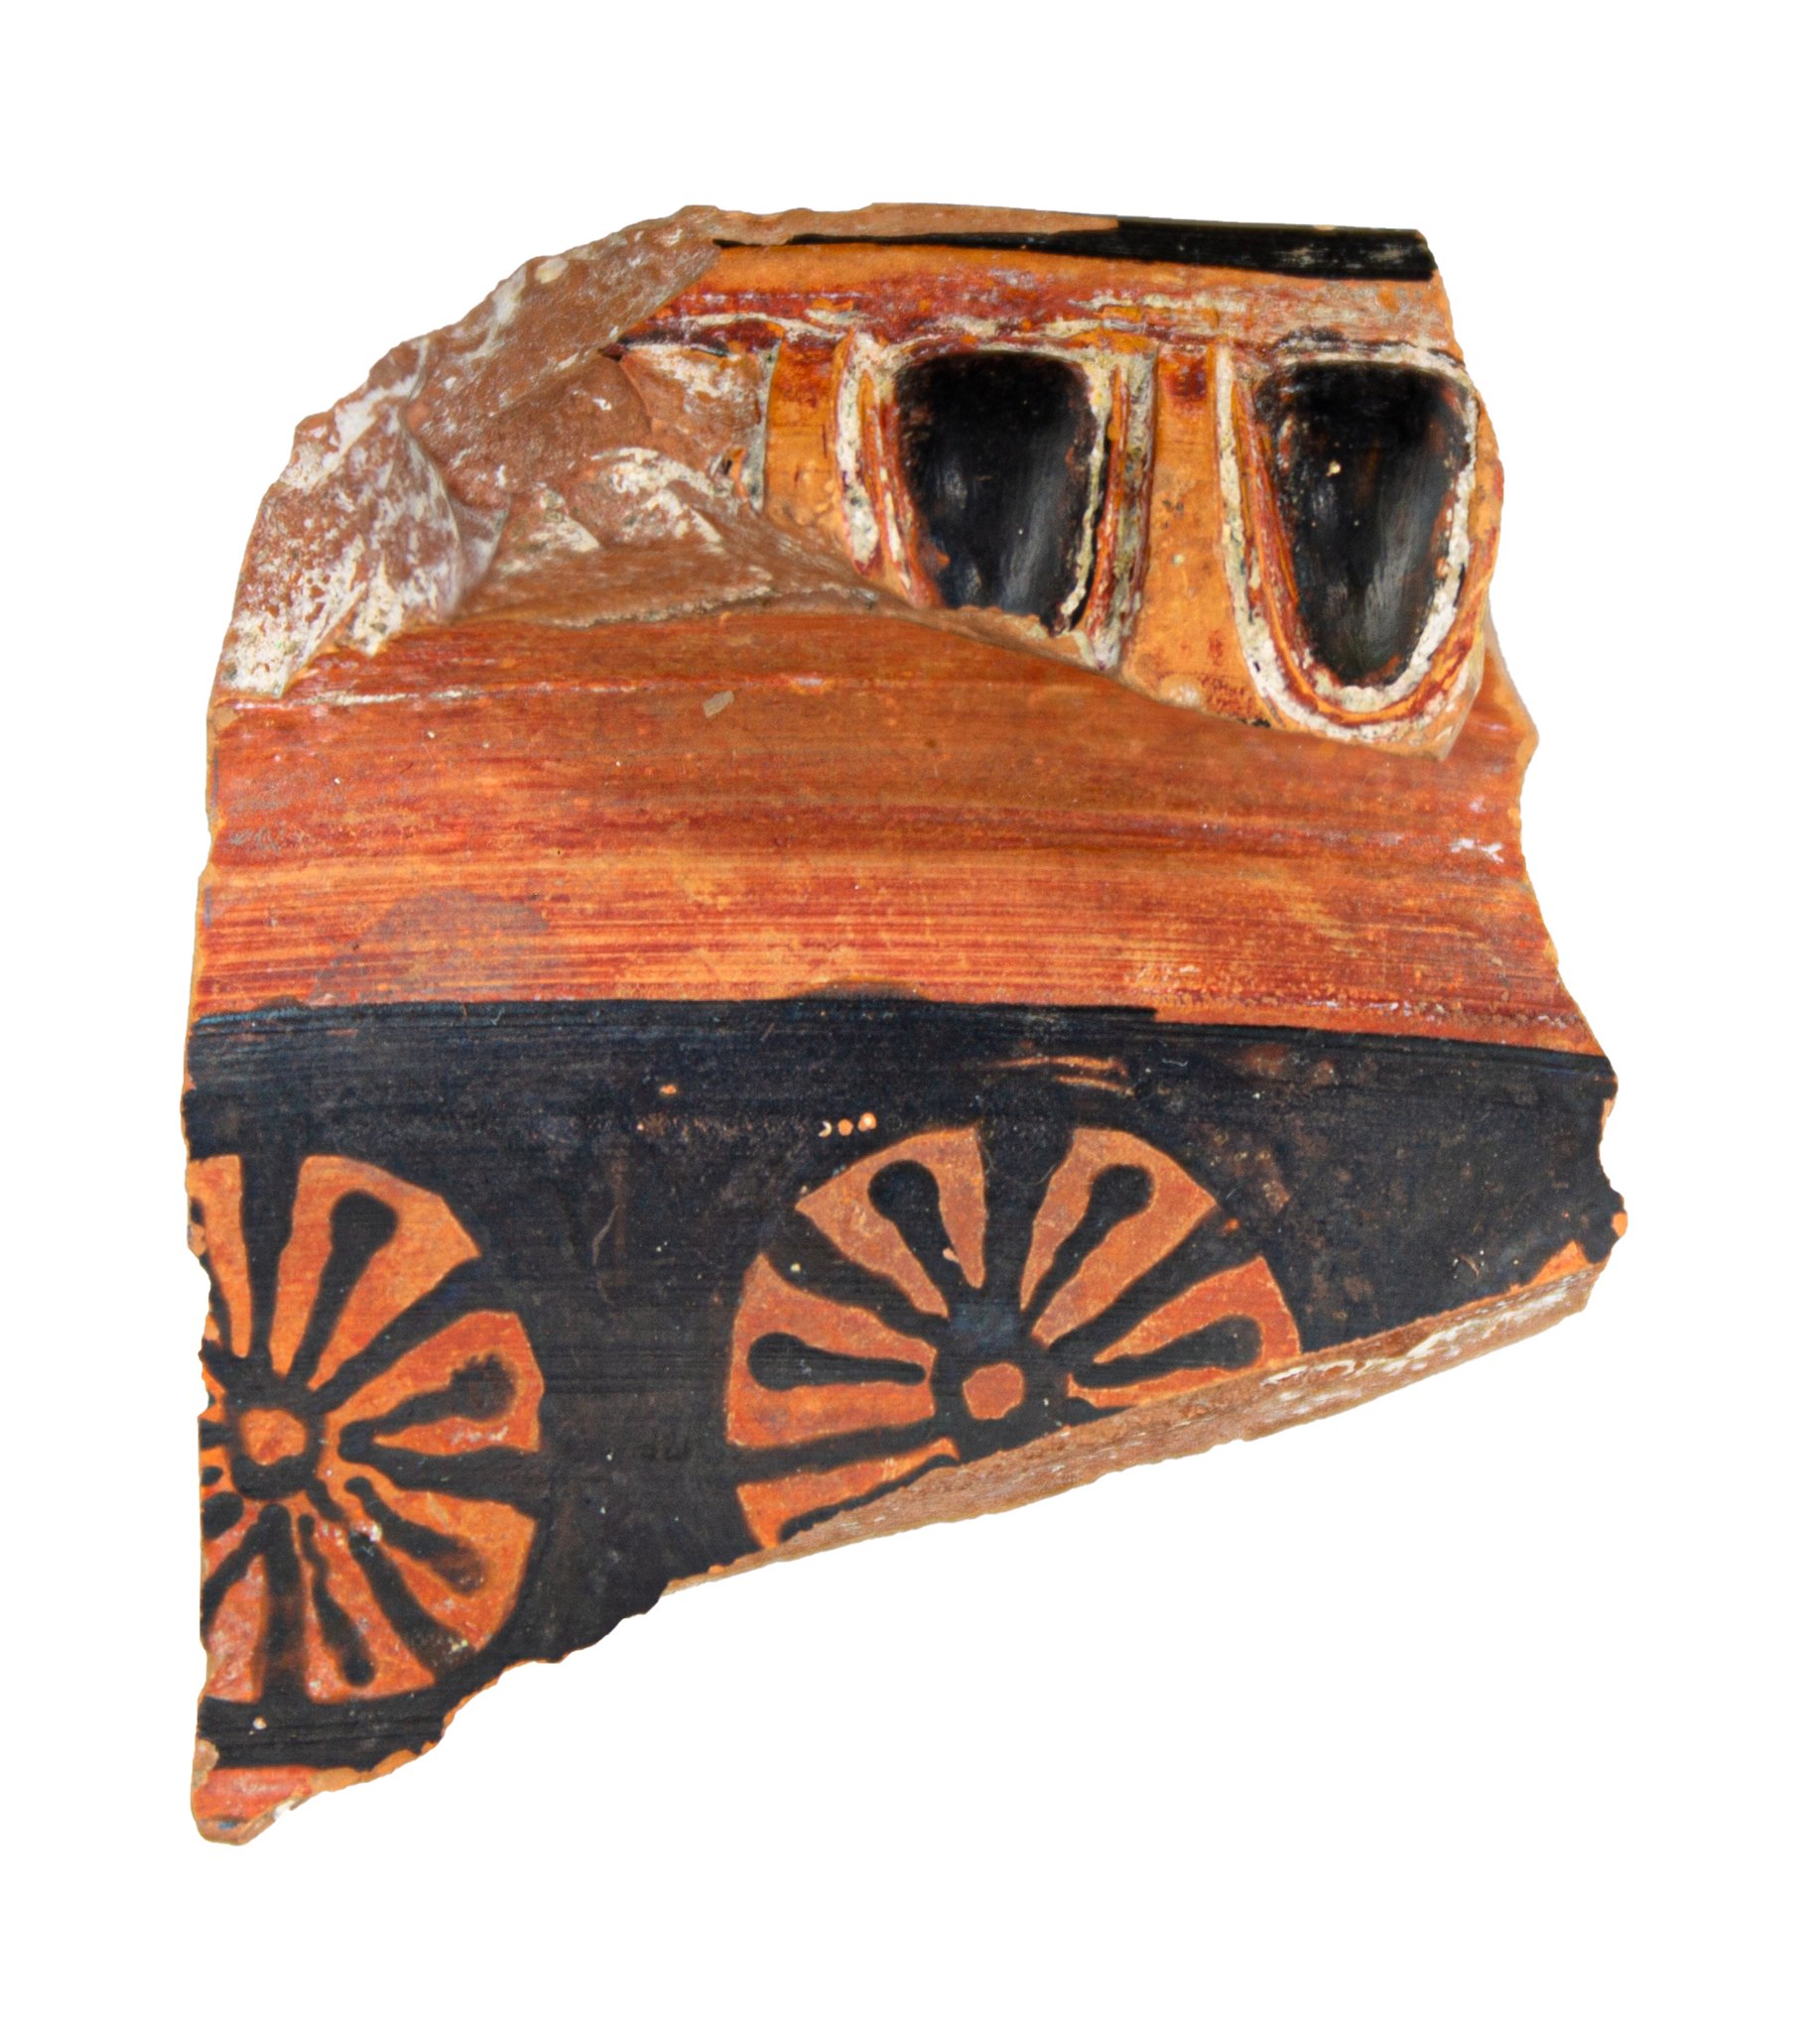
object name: volute krater fragment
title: Volute-krater fragment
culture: greek, south italian, apulian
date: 360-340 BCE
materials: terracotta